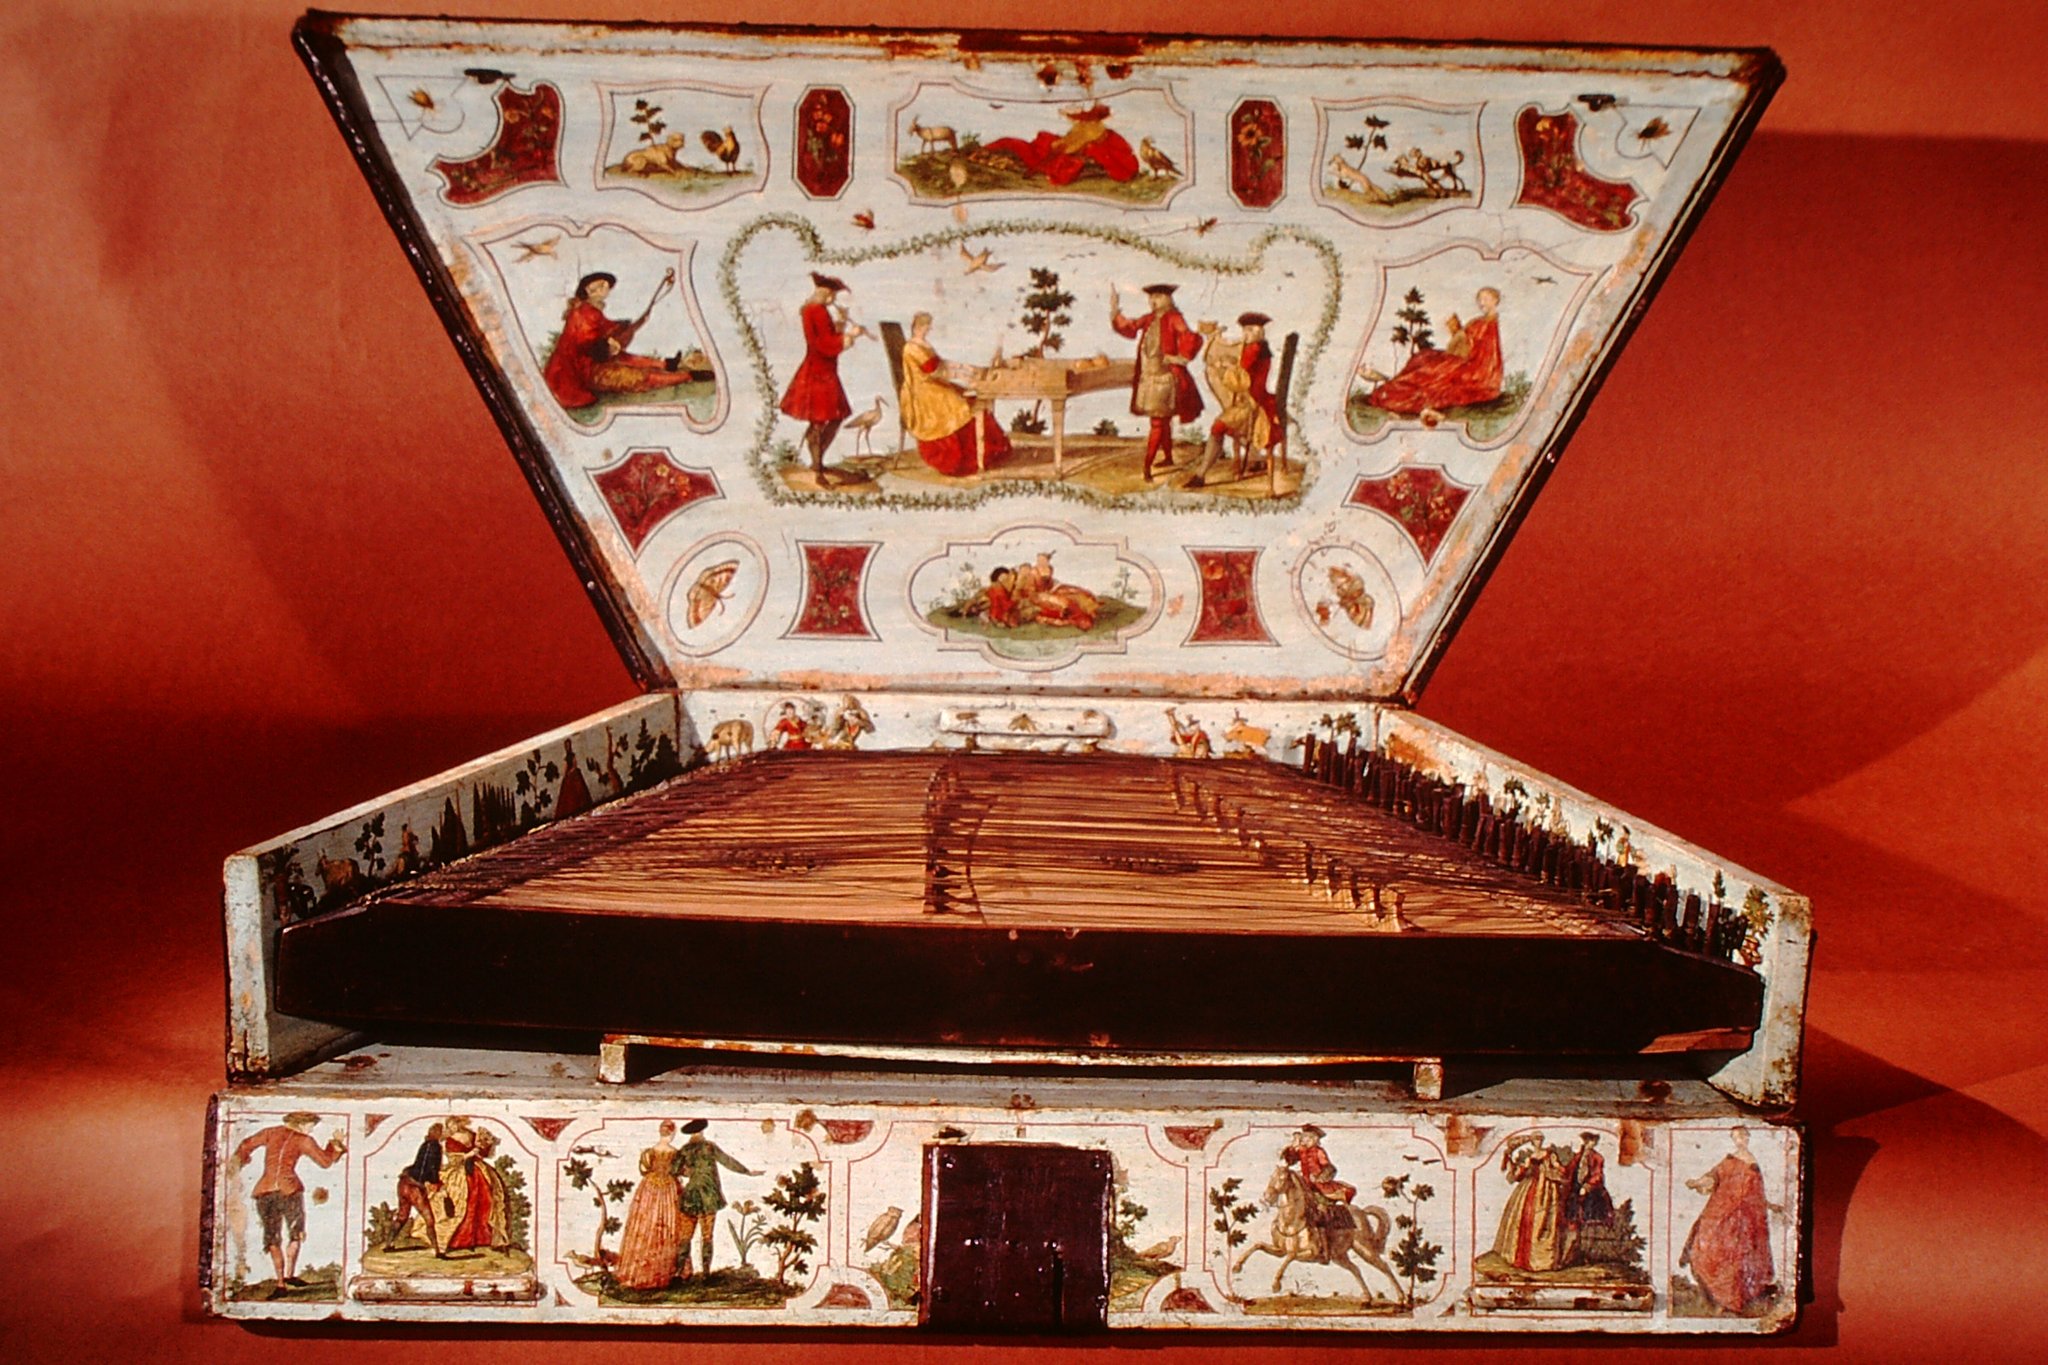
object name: dulcimer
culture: italian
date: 1701-1800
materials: wood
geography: italy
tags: animals,men,women,musicians